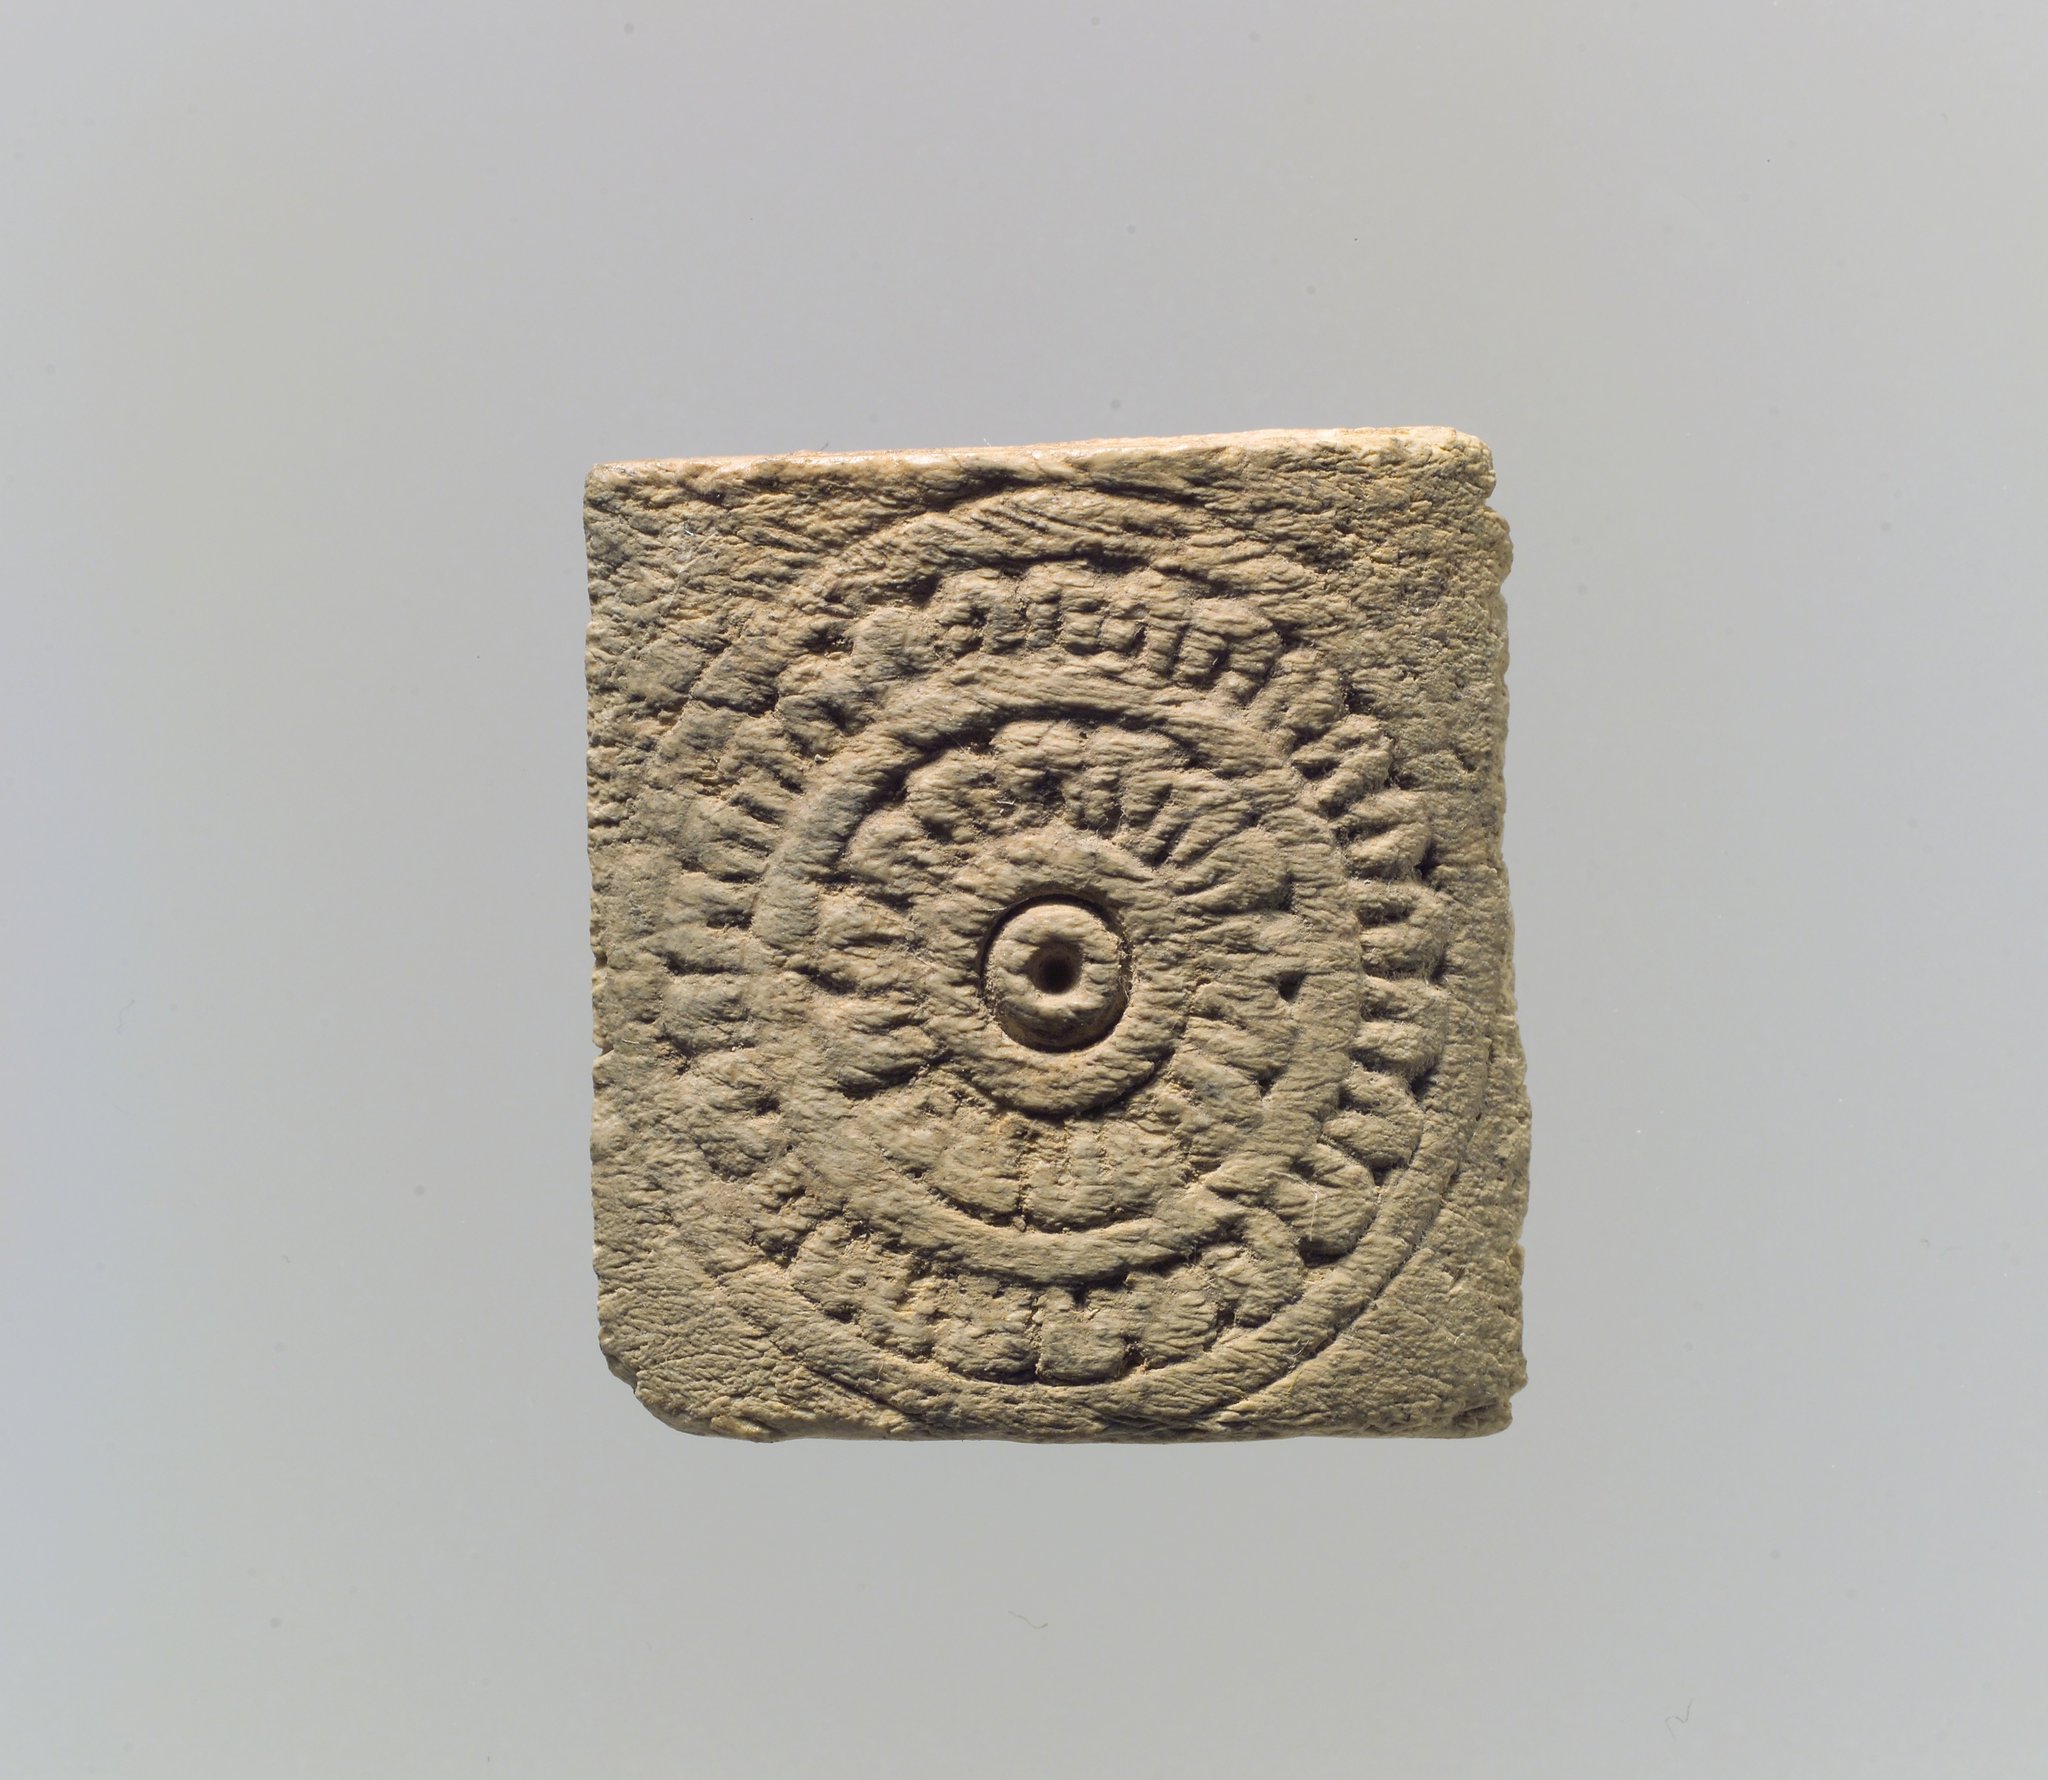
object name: relief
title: Plaque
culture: iranian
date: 800-601 BCE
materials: ivory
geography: iran